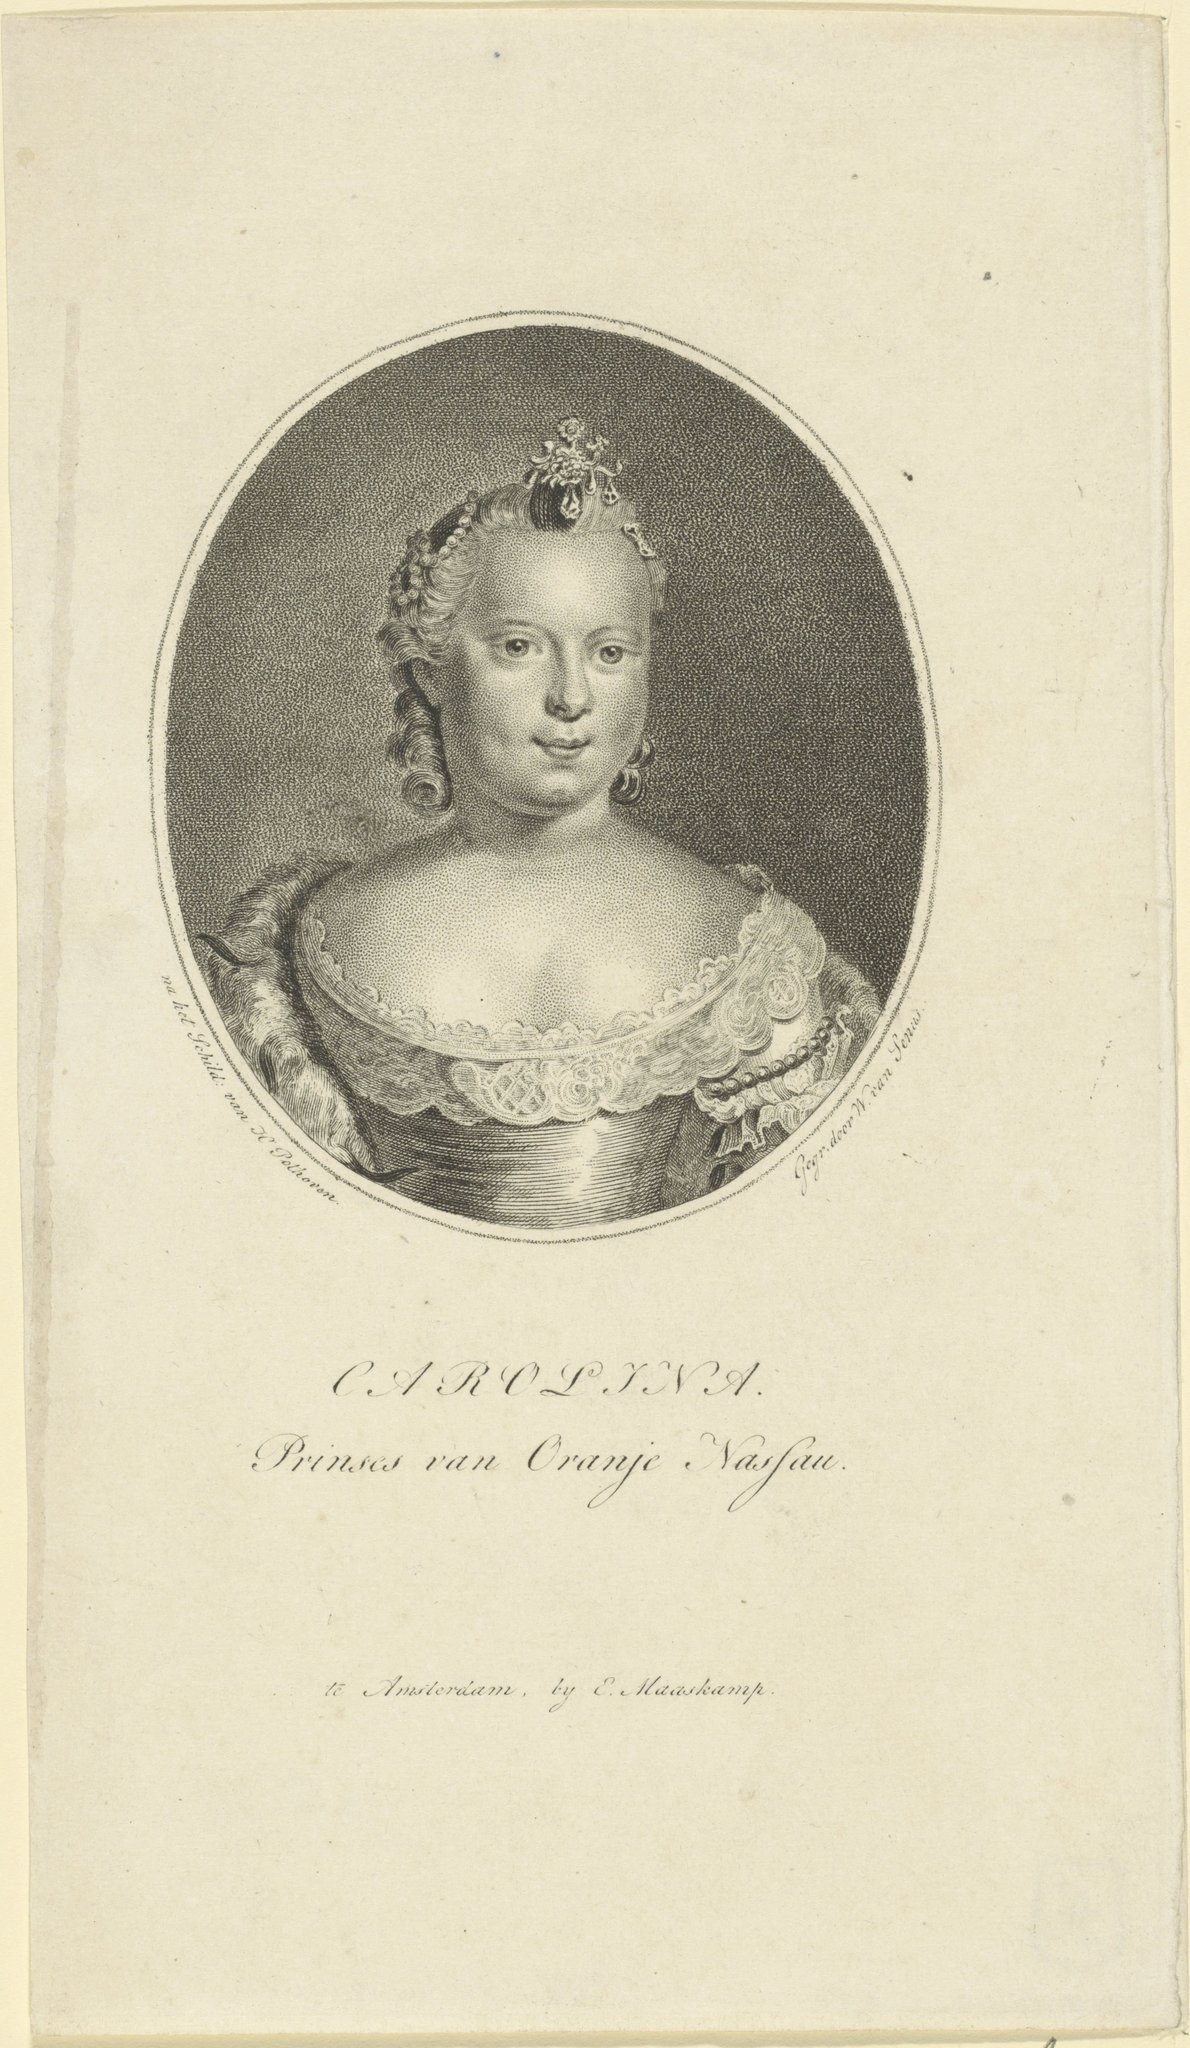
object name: print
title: Portret van Carolina, prinses van Oranje-Nassau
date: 1787-1834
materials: paper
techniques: engraving, etching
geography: northern netherlands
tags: carolina (prinses van oranje-nassau)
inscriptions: collector's mark: Lugt 963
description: De hier vermelde titel verwijst naar de hoogst verkregen titel van de geportretteerde, niet per se naar de titel die de geportretteerde op deze voorstelling draagt.